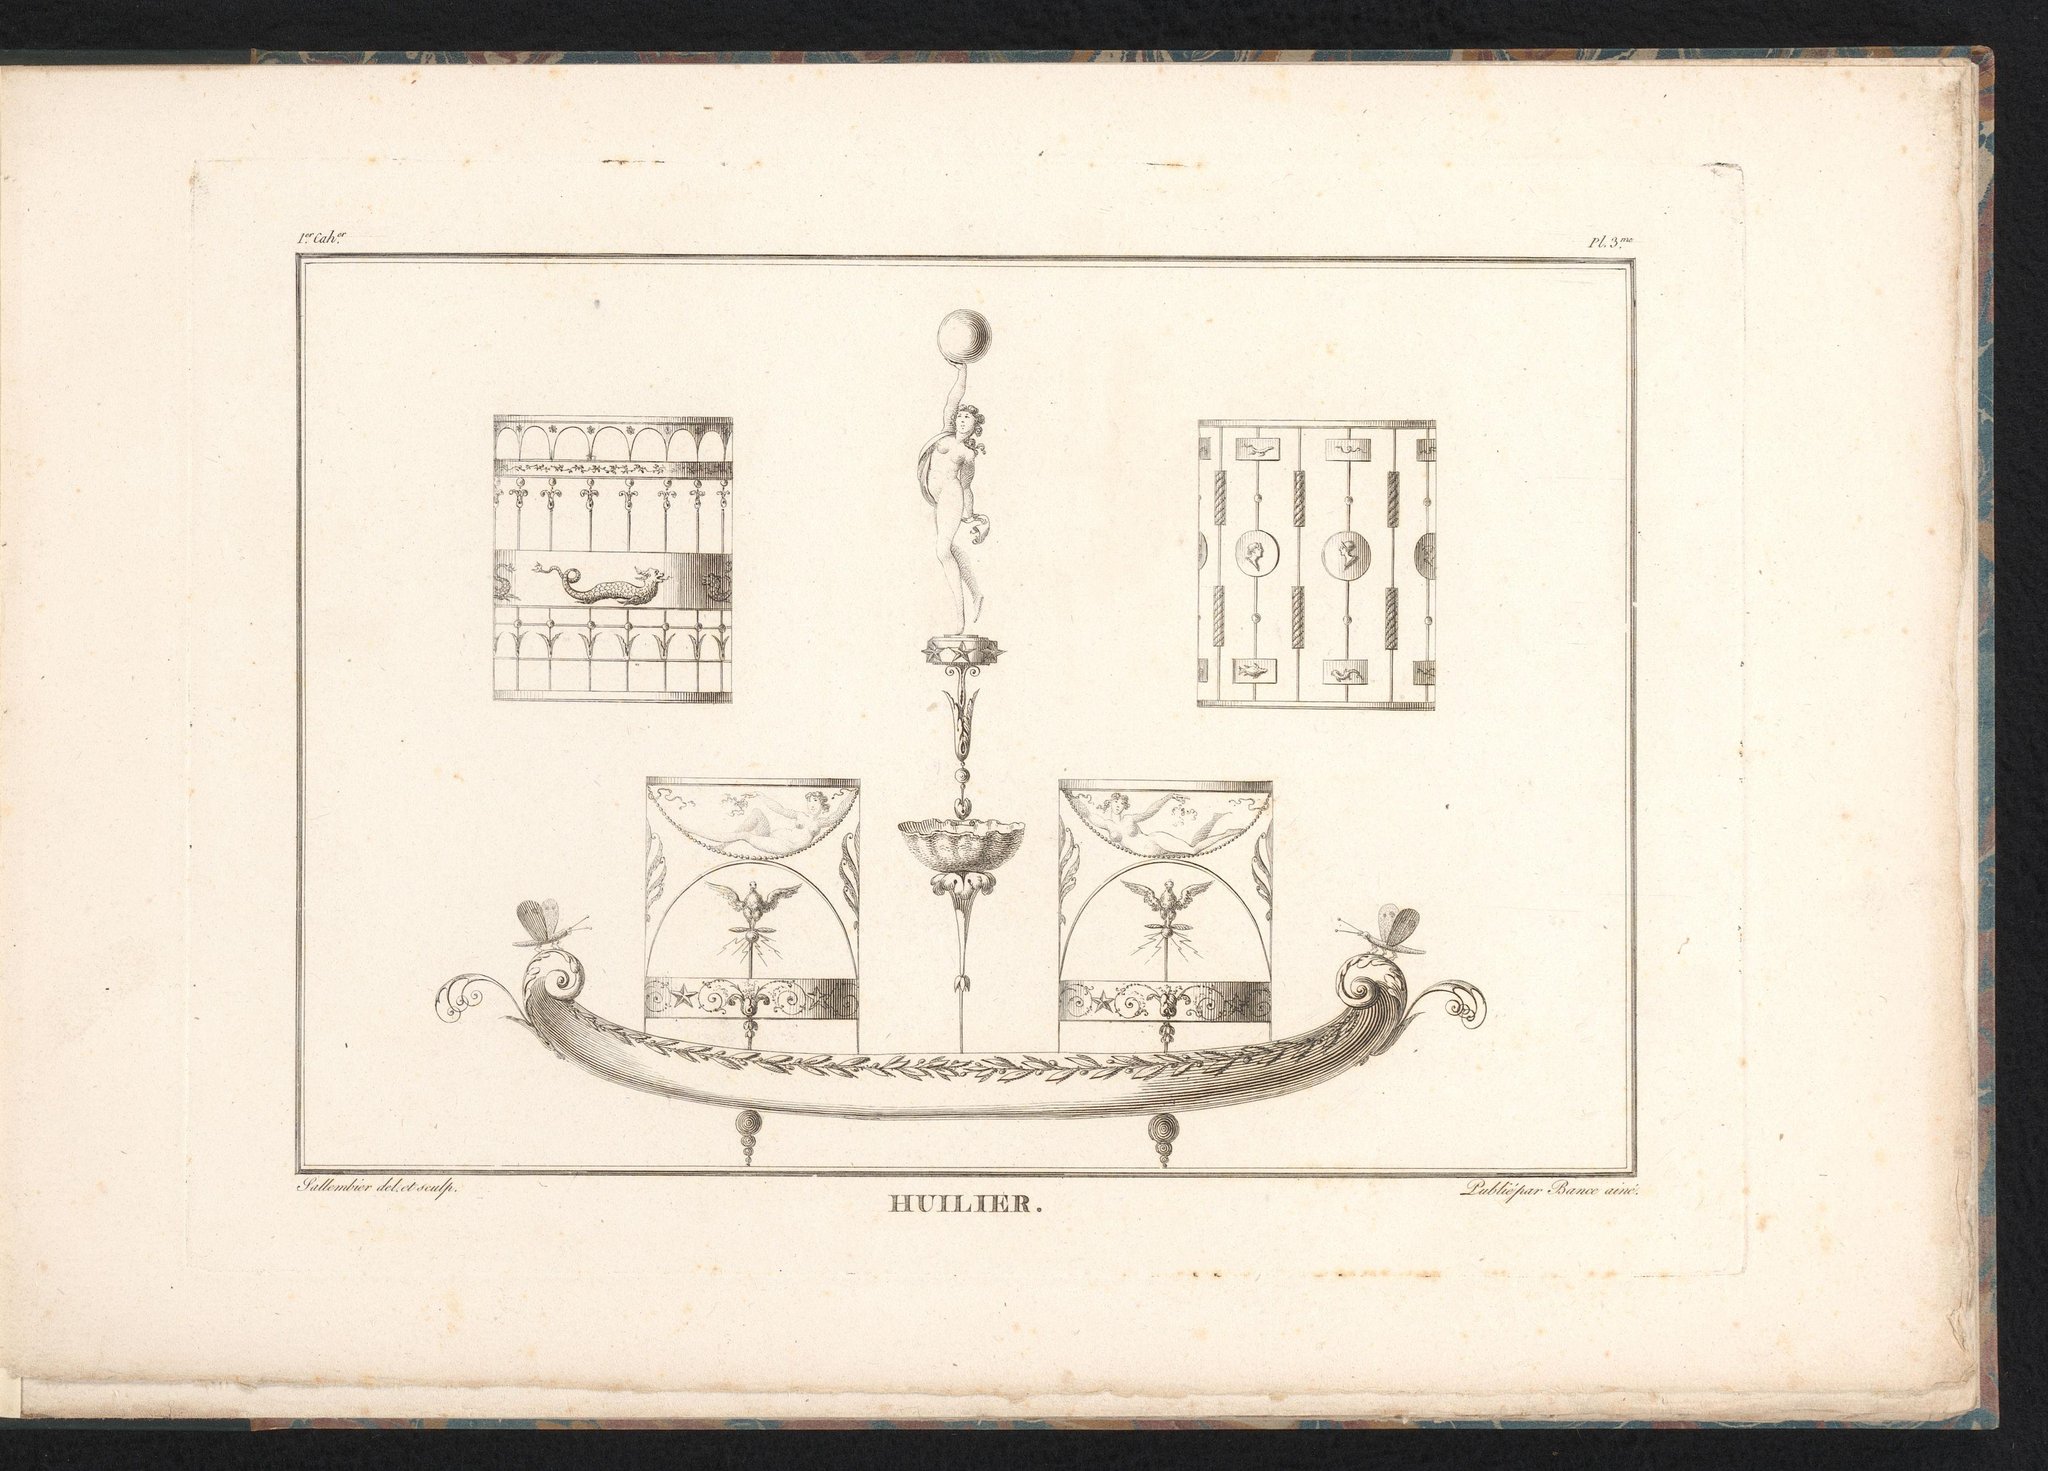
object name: album leaf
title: Modèles d'Orfèvrerie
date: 1805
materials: paper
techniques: etching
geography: paris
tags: oil, vinegar, sauces, dinner-service, single muses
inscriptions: number: ‘1.er Cah.er’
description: Ontwerp voor een houder voor twee flessen olie en azijn met decoratie van vlinders, vogels en muzen. Prent maakt deel uit van een album.